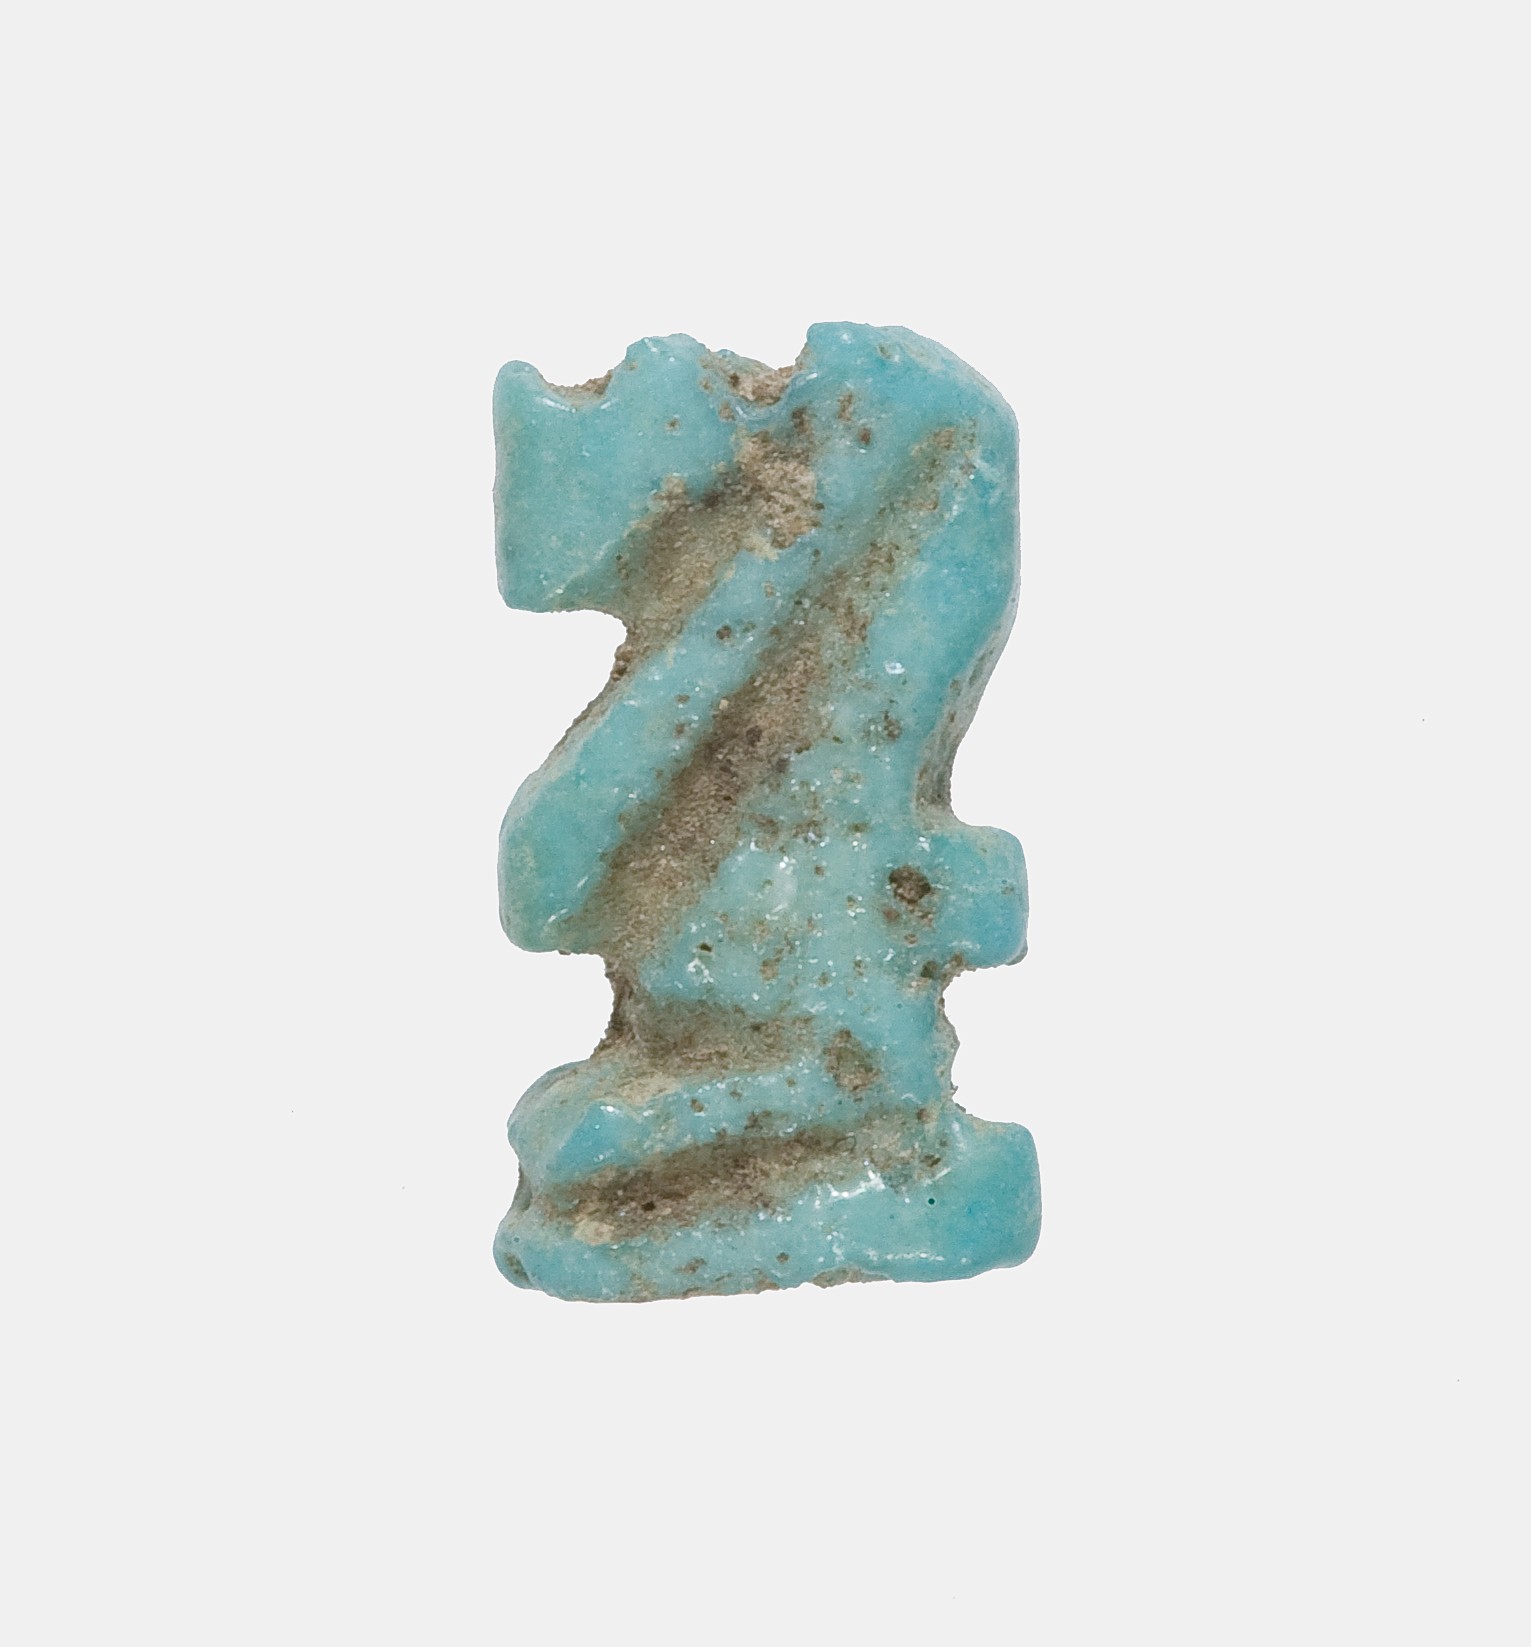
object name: amulet, baboon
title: Baboon Amulet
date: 1802-1450 BCE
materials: faience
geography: egypt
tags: baboons